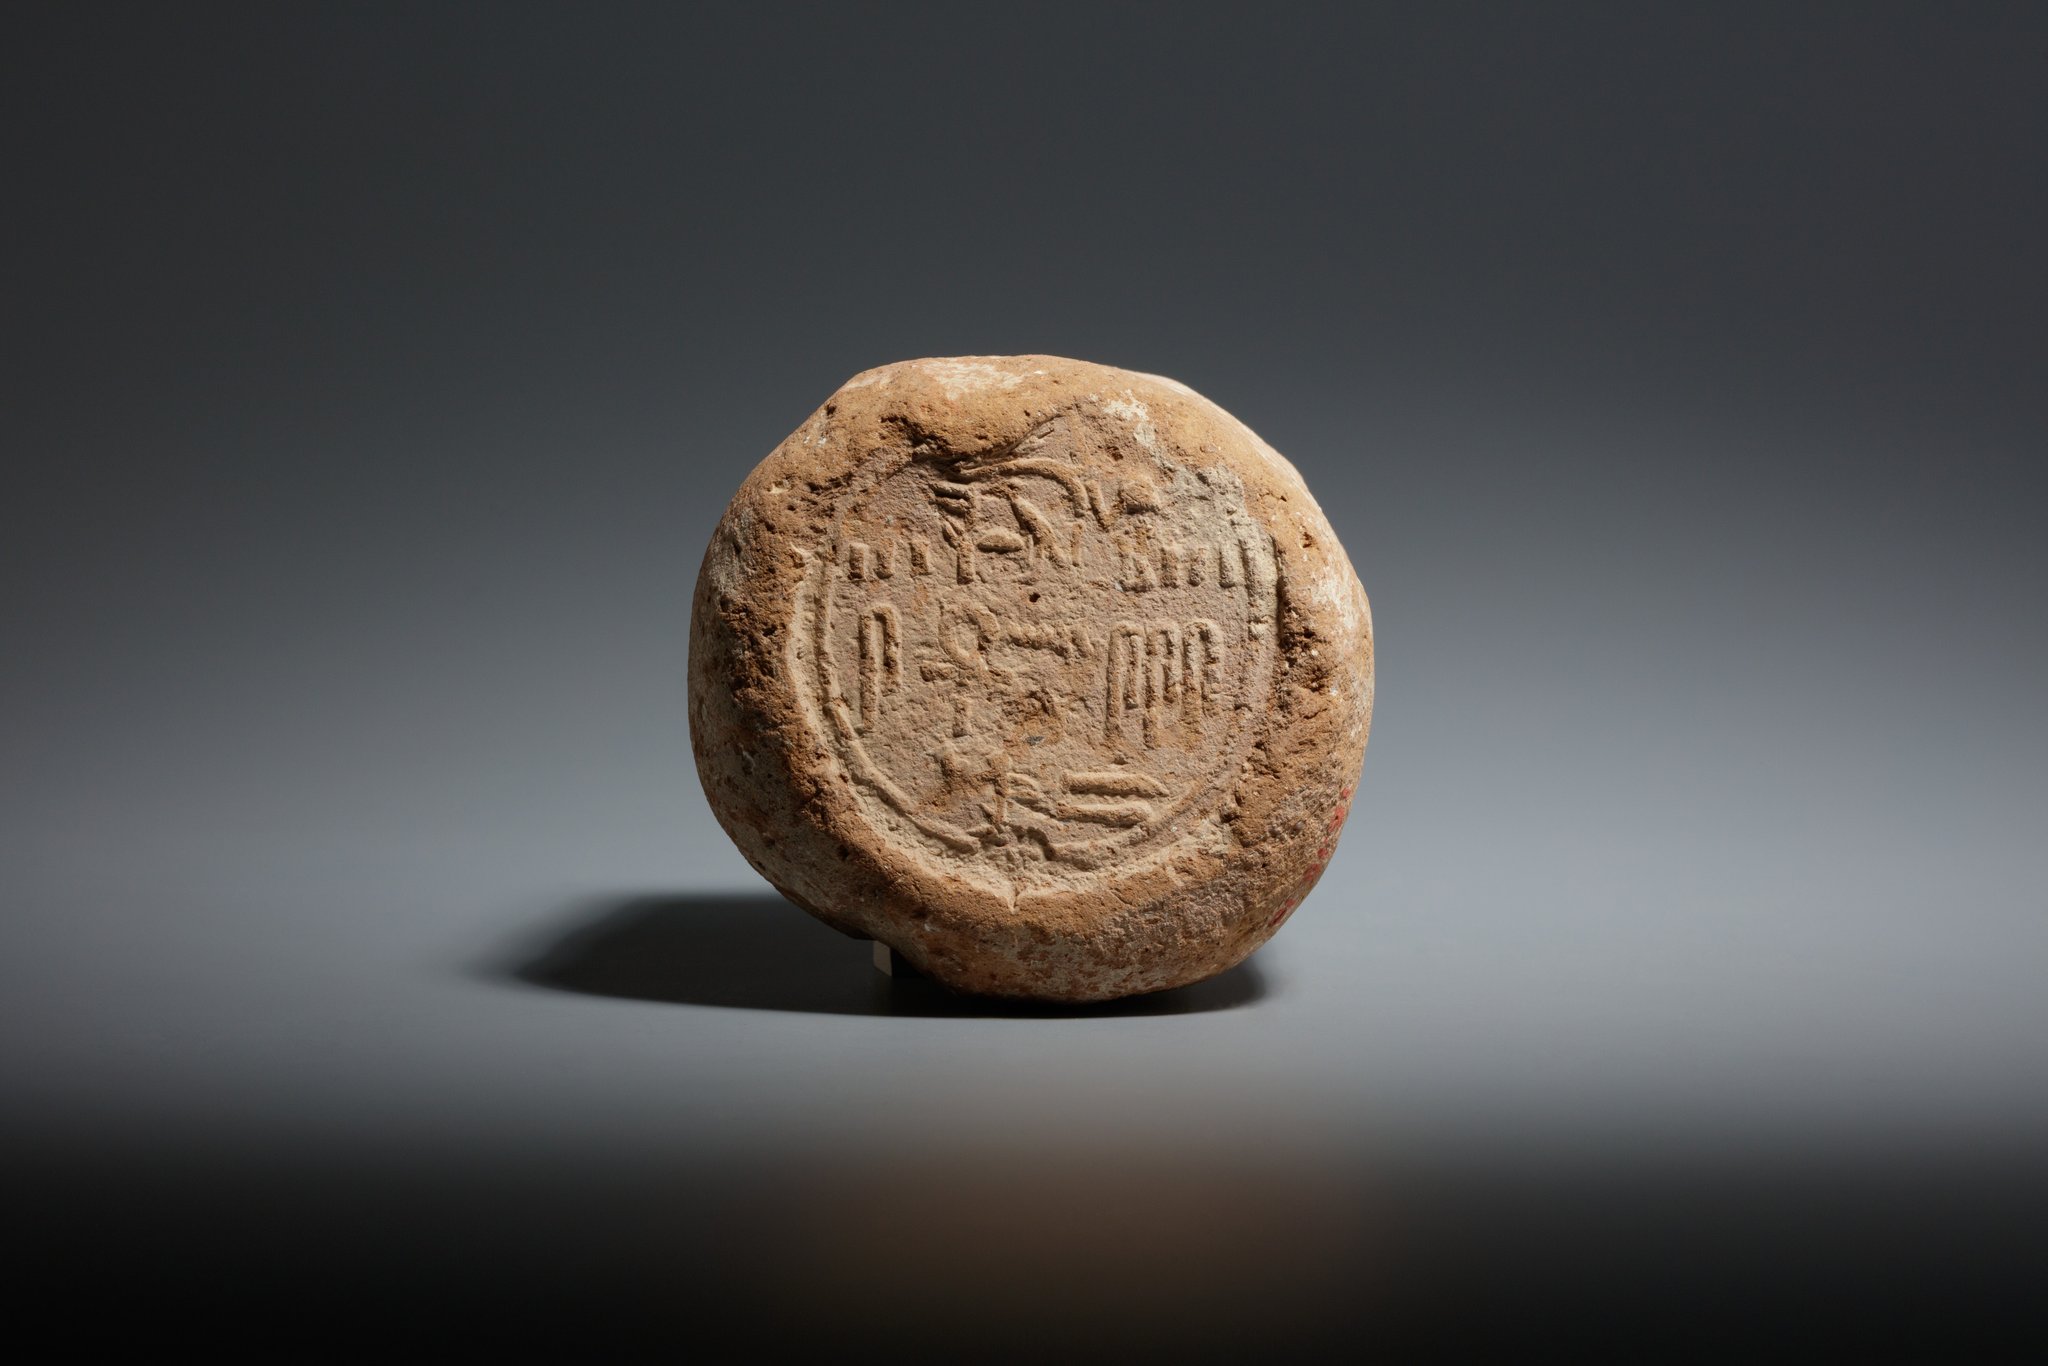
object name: cone, davy 512, su, overseer, sculptor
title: Funerary Cone of the Overseer of Sculptors Su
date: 1550-1295 BCE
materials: pottery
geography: egypt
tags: hieroglyphs